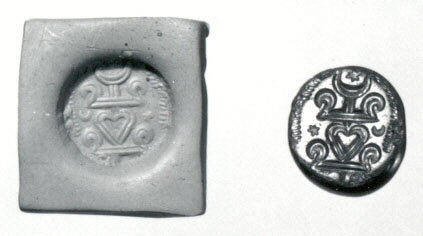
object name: stamp seal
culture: sasanian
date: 201-700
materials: jasper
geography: iran or mesopotamia